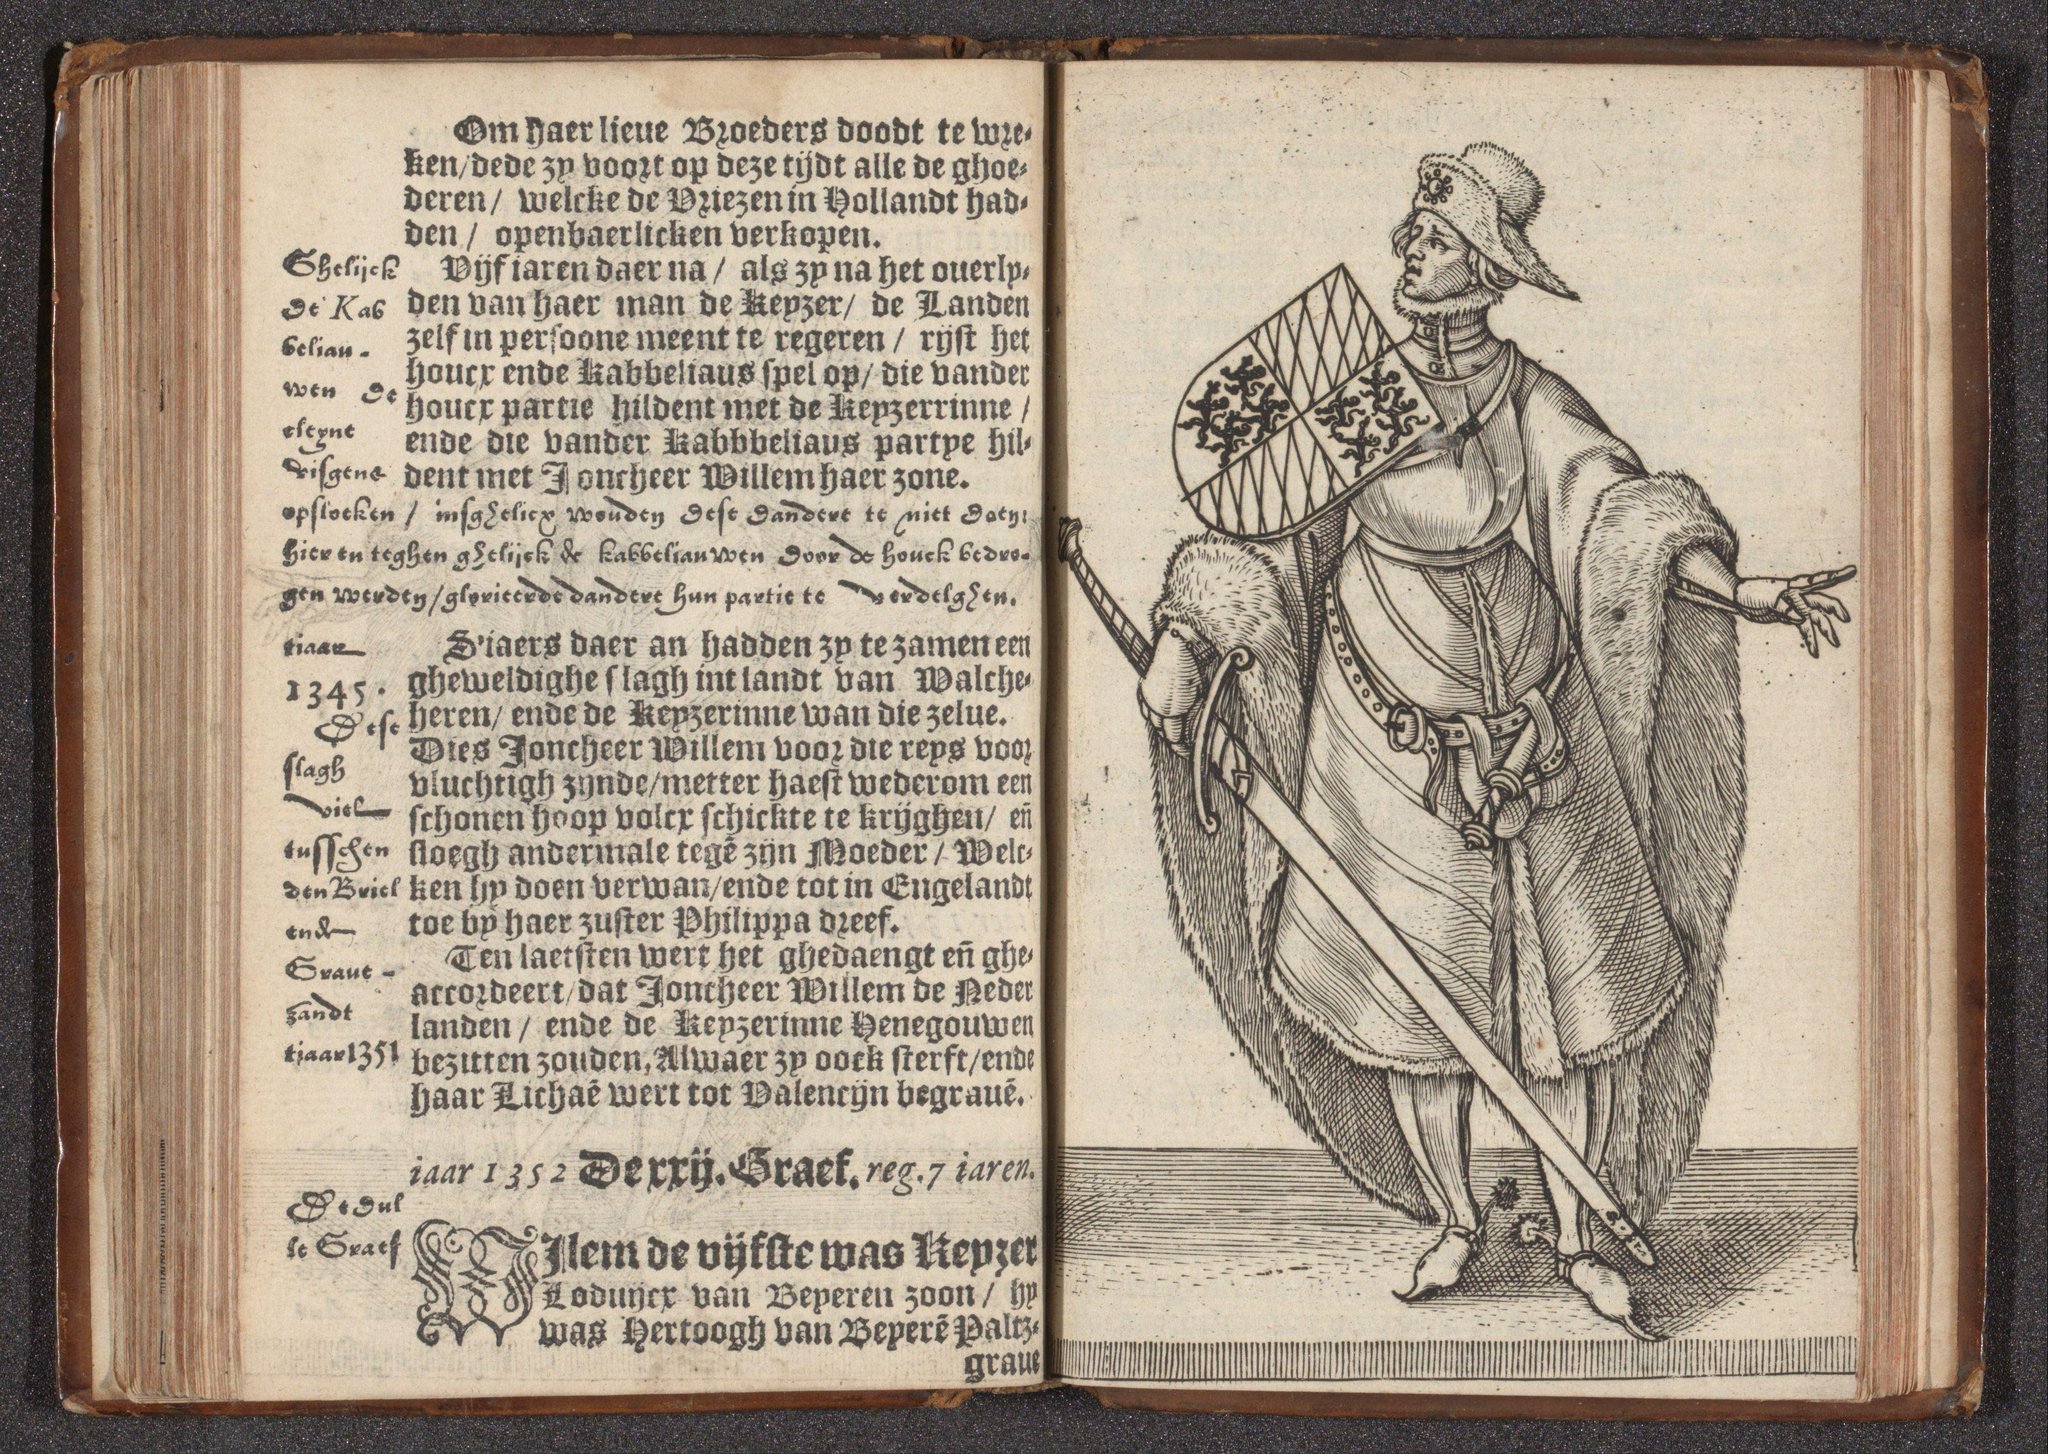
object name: print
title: Graven en gravinnen van Holland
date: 1586-1587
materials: paper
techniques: engraving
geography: haarlem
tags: earl, willem v van holland (graaf van holland en zeeland), historical persons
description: Graaf Willem V van Holland, ten voeten uit, met zwaard. Zijn wapenschild heeft vier kwartieren: twee met vier klimmende leeuwen en twee met diagonalen. De prent maakt deel uit van een boek met beschrijvingen en voorstellingen van de graven van Holland, Zeeland en Friesland.